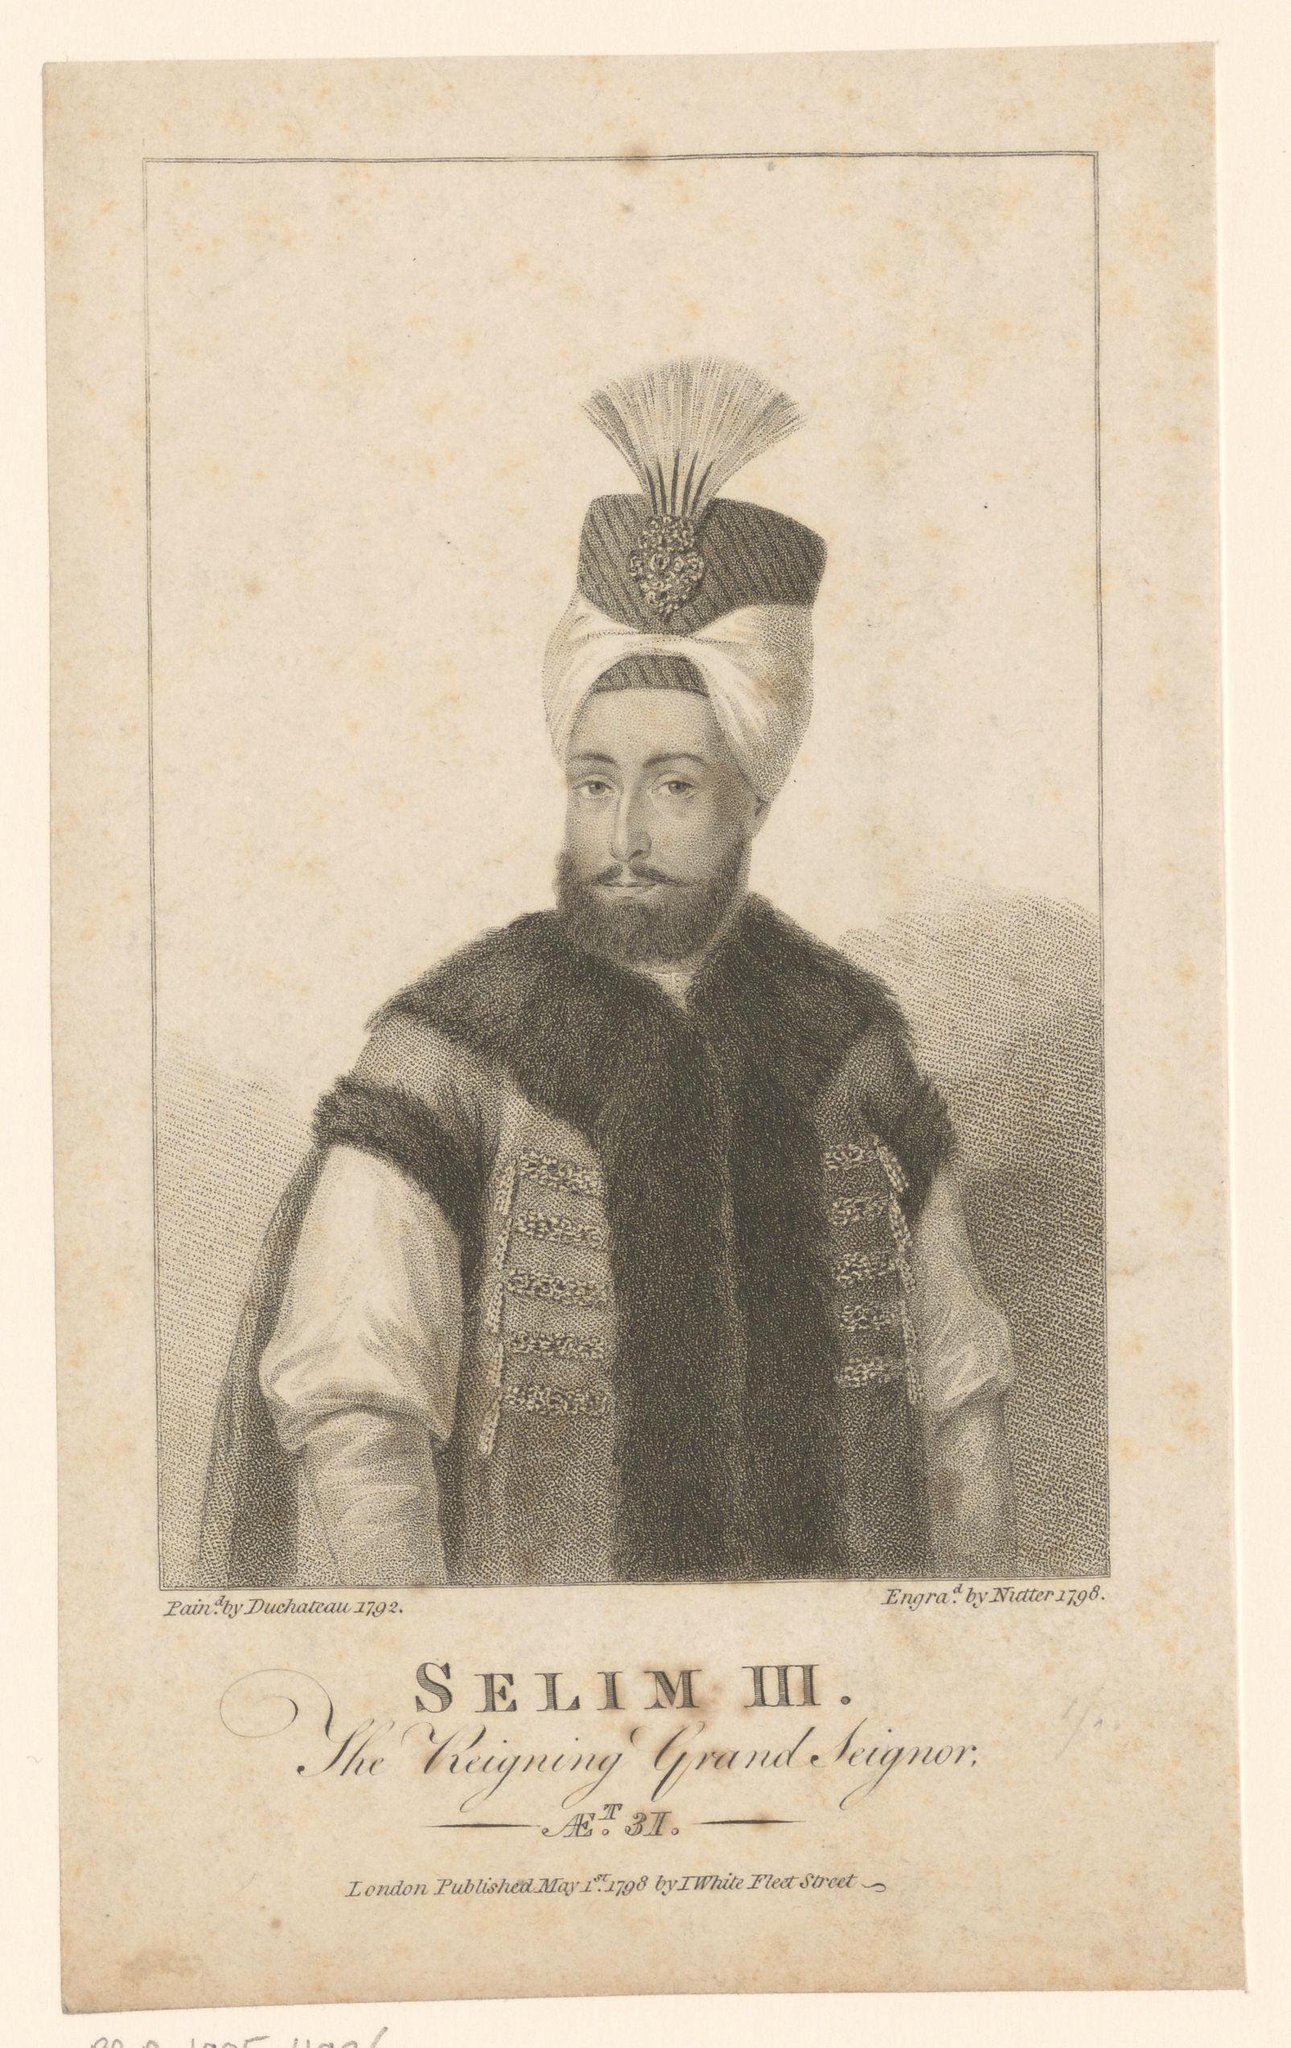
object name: print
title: Selim III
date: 1798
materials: paper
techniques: etching, engraving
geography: london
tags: historical persons, ruler, sovereign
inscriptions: collector's mark: Lugt 2228